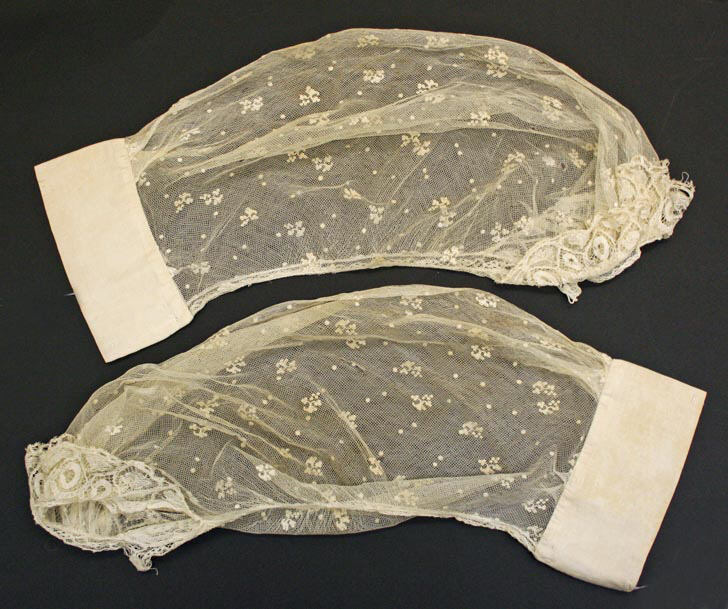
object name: sleeve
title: Sleeves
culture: american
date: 1860-1869